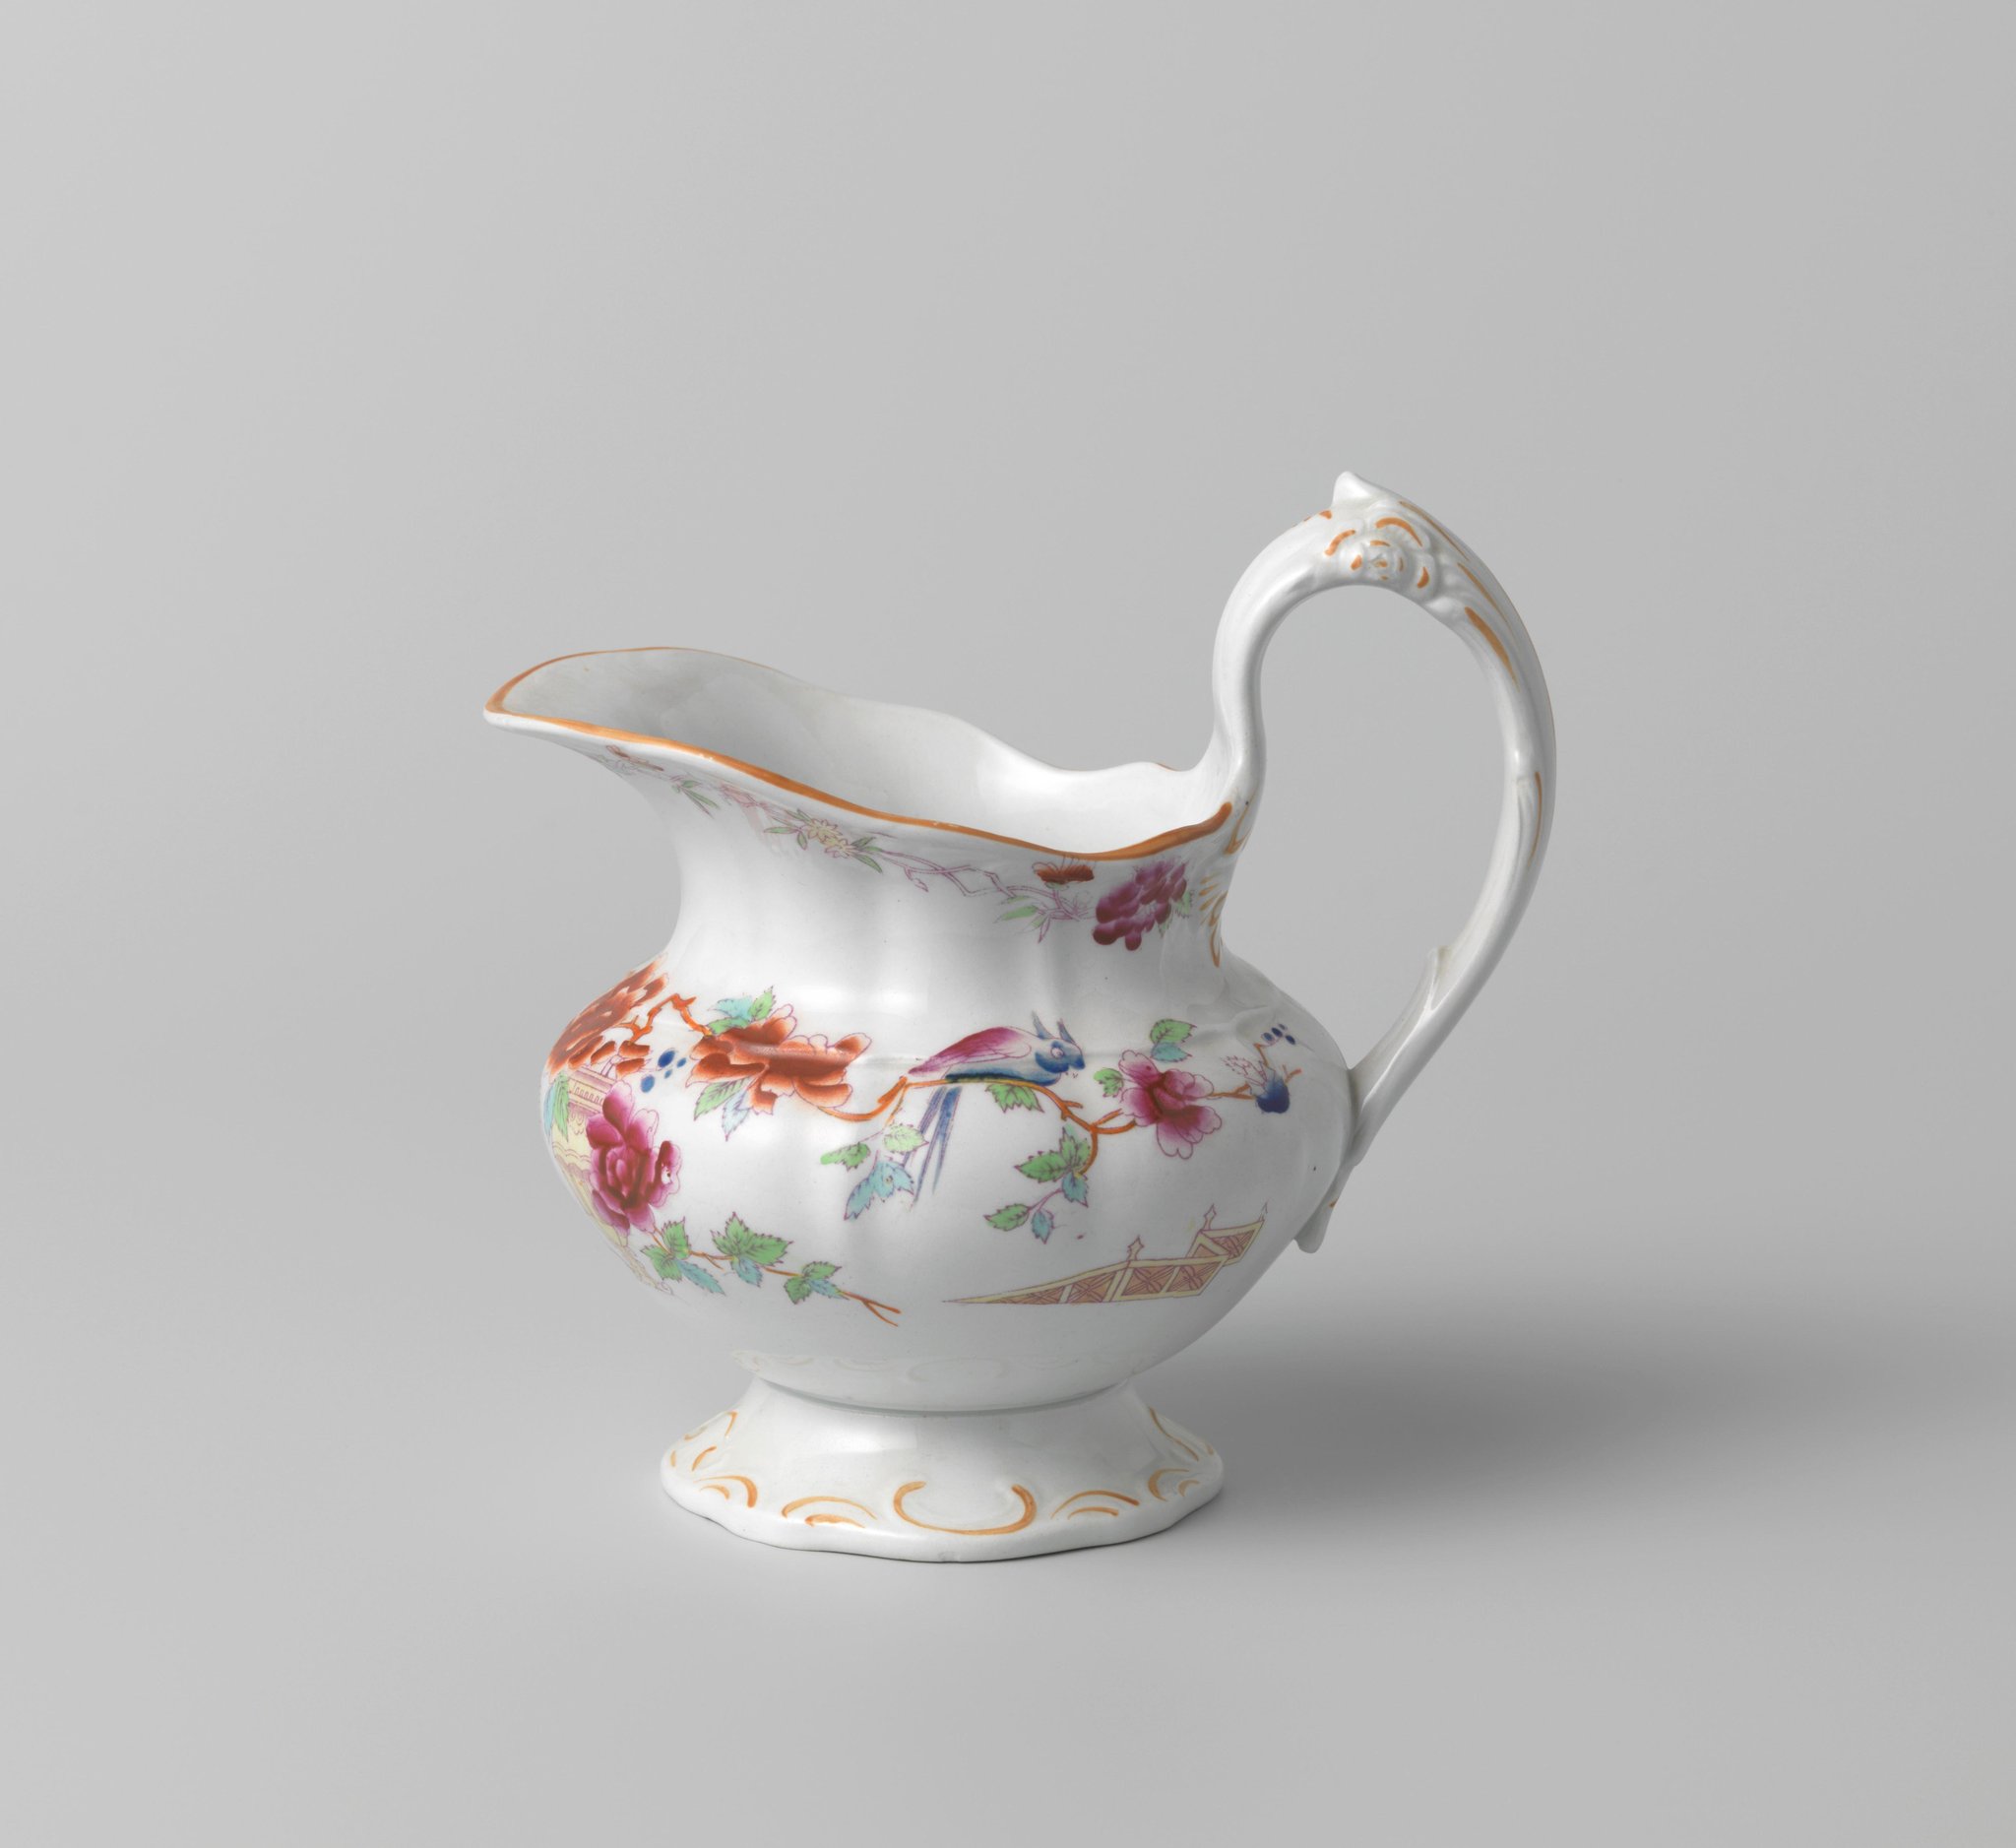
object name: milk jug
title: Melkkan, met veelkleurig decor met een tuinvaas, een hek en bloemen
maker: petrus regout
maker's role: plateelbakker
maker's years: 1801-1879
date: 1860-1890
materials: creamware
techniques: muffling, transfer decoration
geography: maastricht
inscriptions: check stamp: ‘8 // P. REGOUT // MAASTRICHT. 1x’, mark: ‘PORTICI // PIERRE. REGOUT’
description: Melkkan van aardewerk met lila transferdecor en moffelkleuren. Het veellobbig lichaam veelkleurig gedecoreerd met een tuinvaas, waar omheen bloemen en bladeren, een hek en een vogel. Langs de bovenrand een band van veelkleurige bloemen en bladeren. Het c-vormige oor in de vorm van gestileerd bladwerk. De voet- en bovenrand zijn afgezet met een oranje bies.